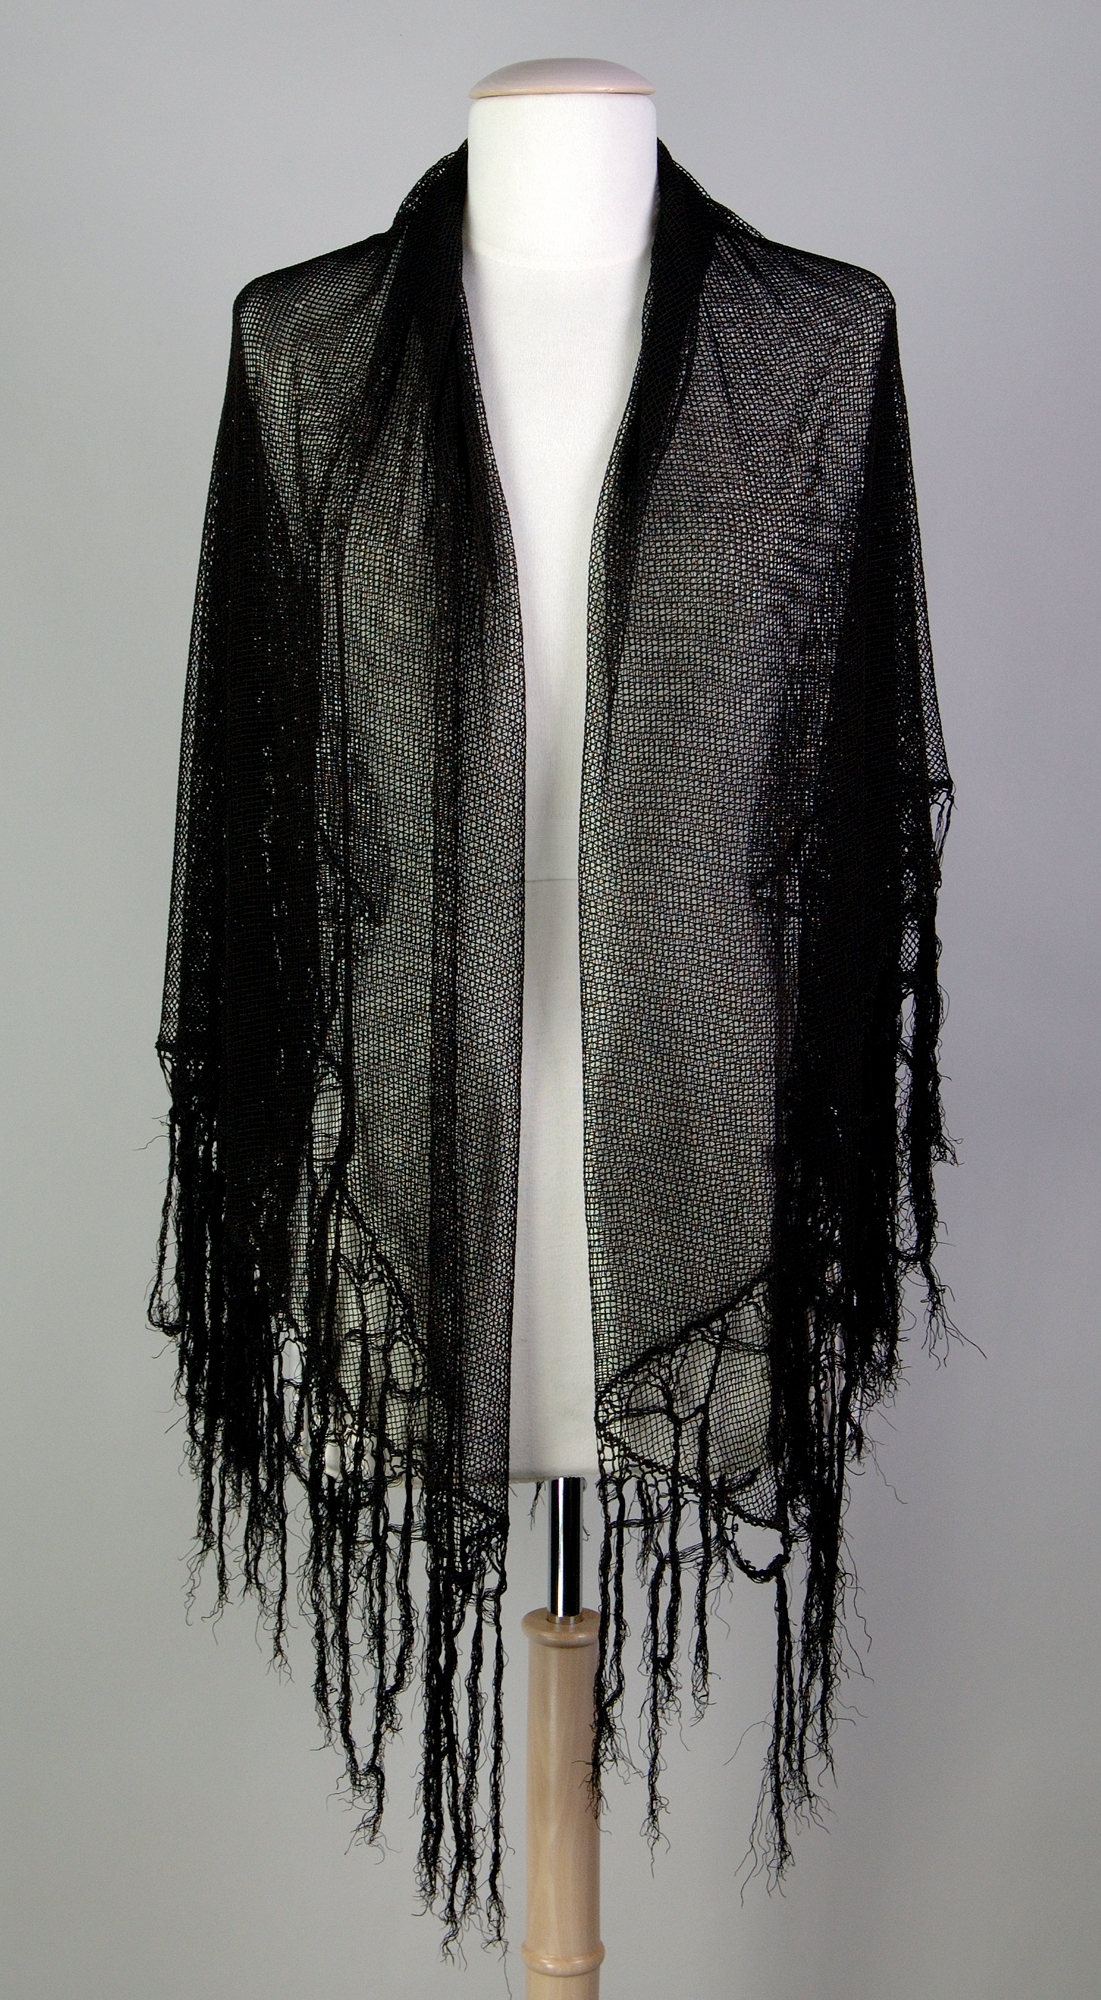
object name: shawl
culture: american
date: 1815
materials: silk